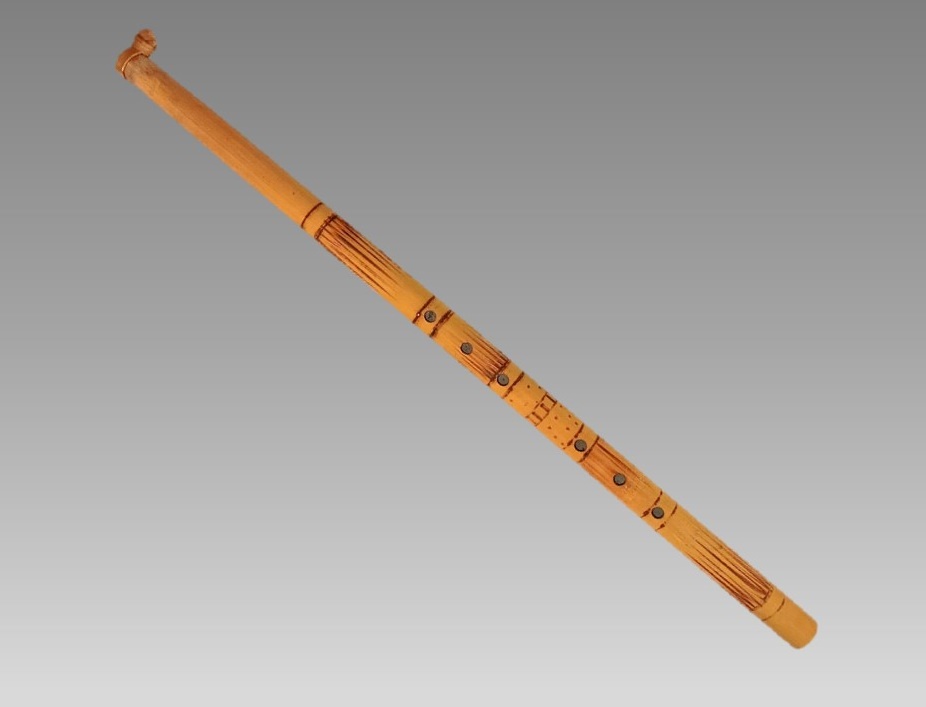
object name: suling pélog ring flute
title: Suling Pelog (ring flute)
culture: javanese, sunda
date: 1801-1900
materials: bamboo, rattan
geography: indonesia